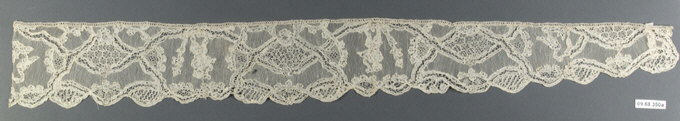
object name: piece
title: Piece (one of three)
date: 1701-1800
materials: lace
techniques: lace